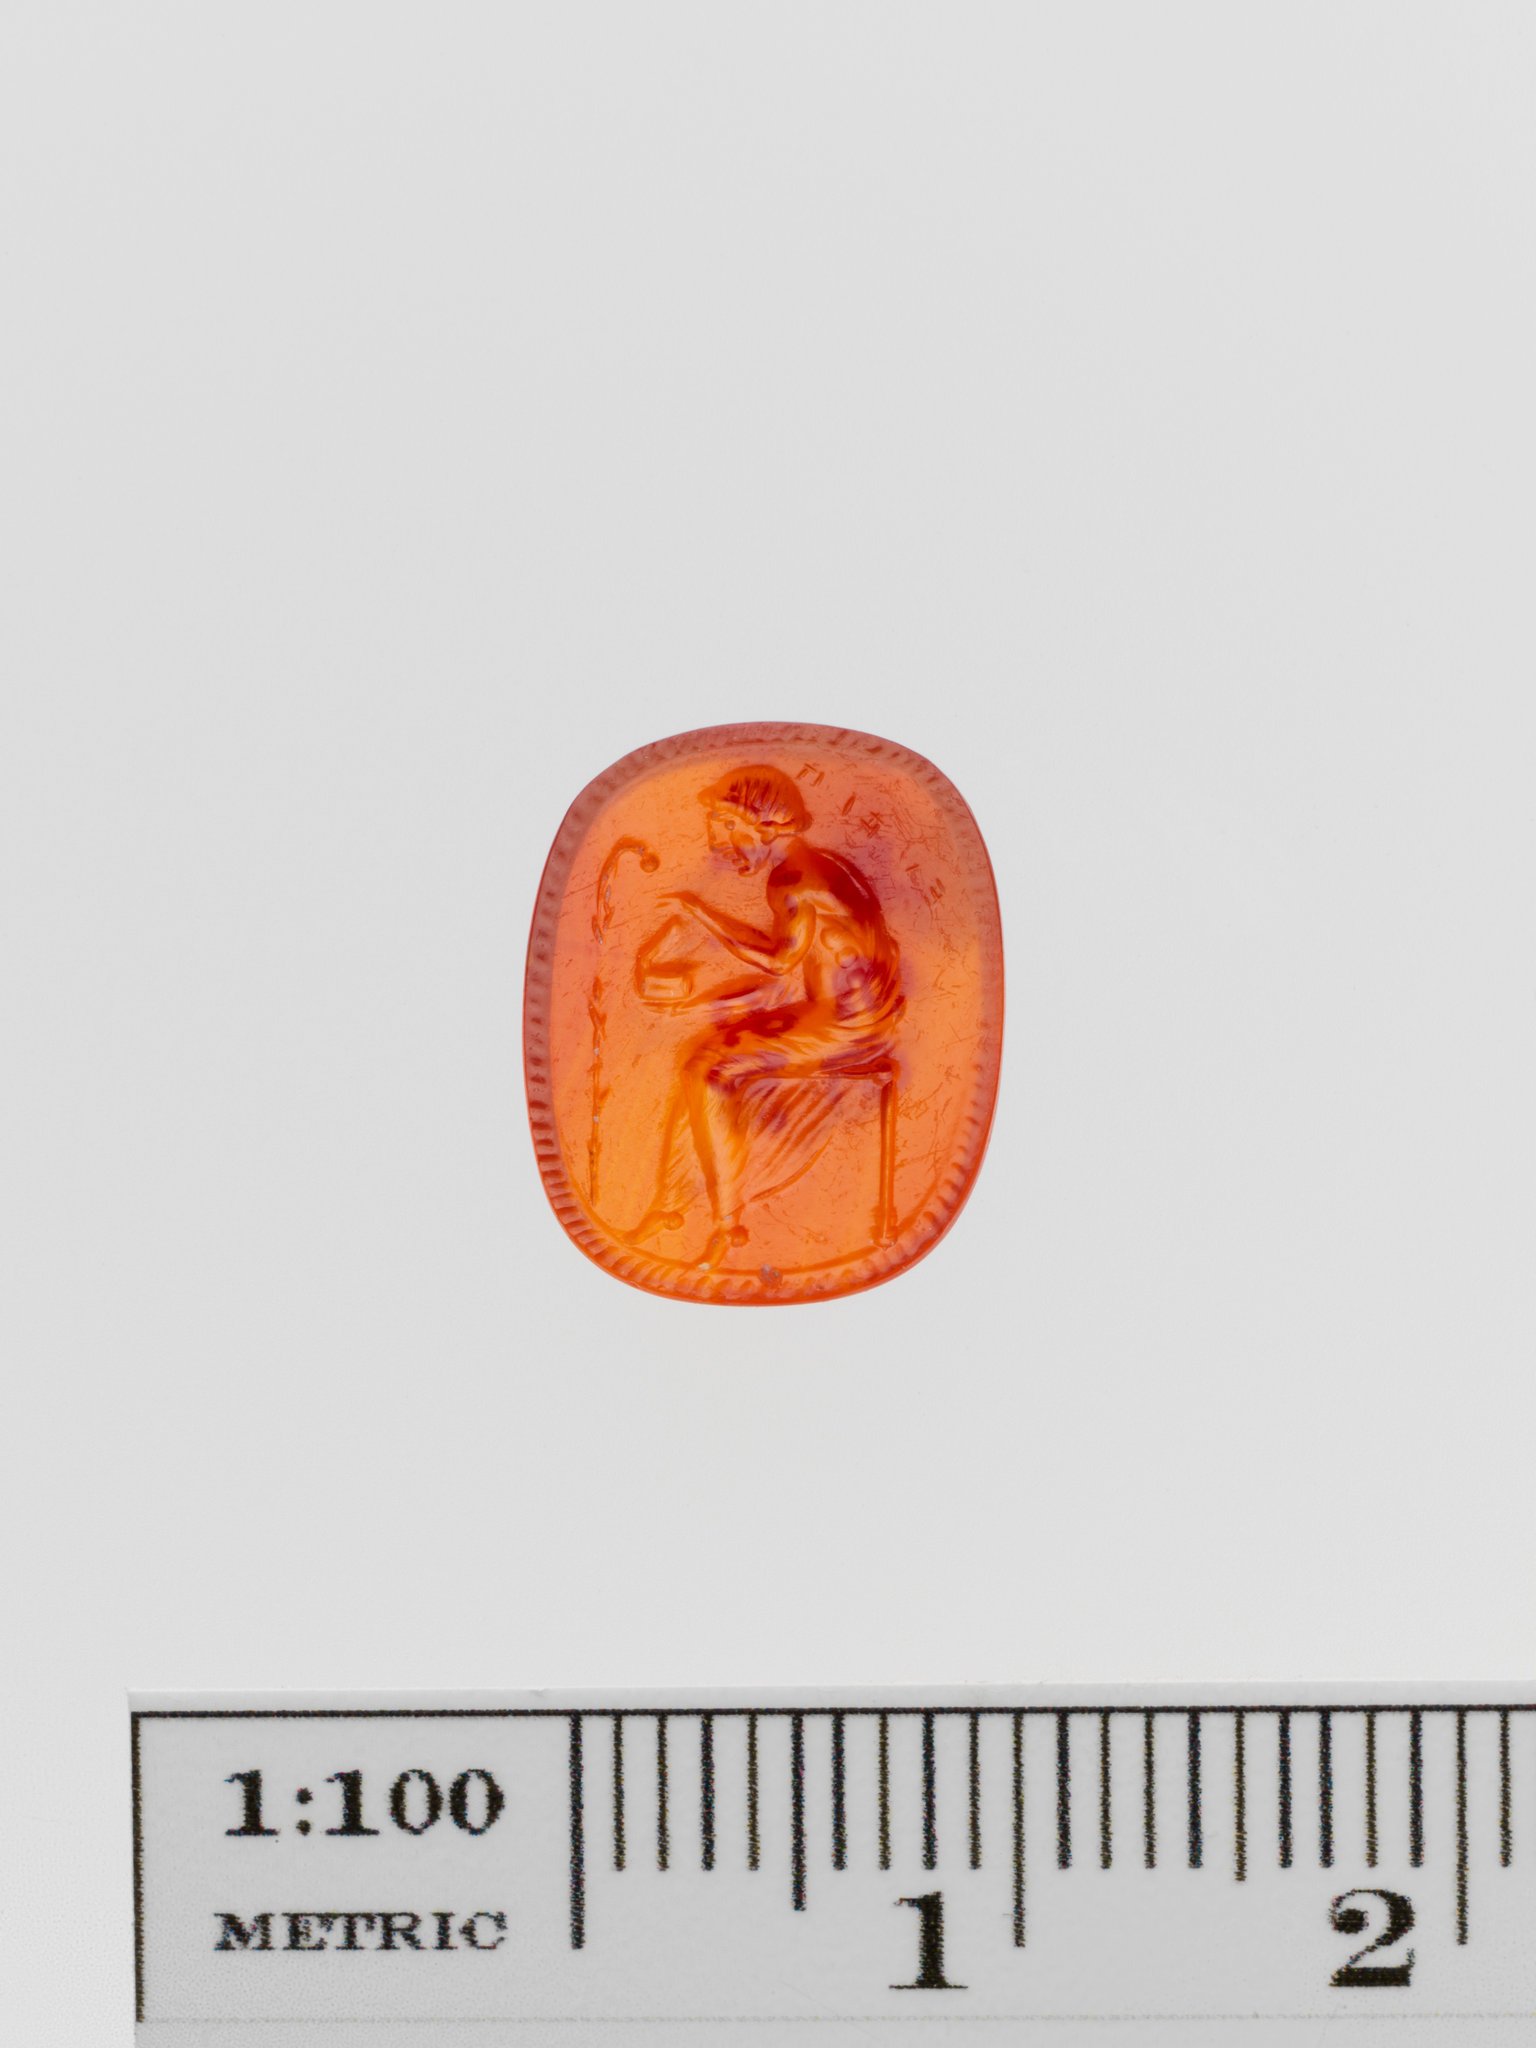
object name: intaglio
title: Carnelian ring stone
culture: italic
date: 300-101 BCE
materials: gemstone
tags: men,stools,chests